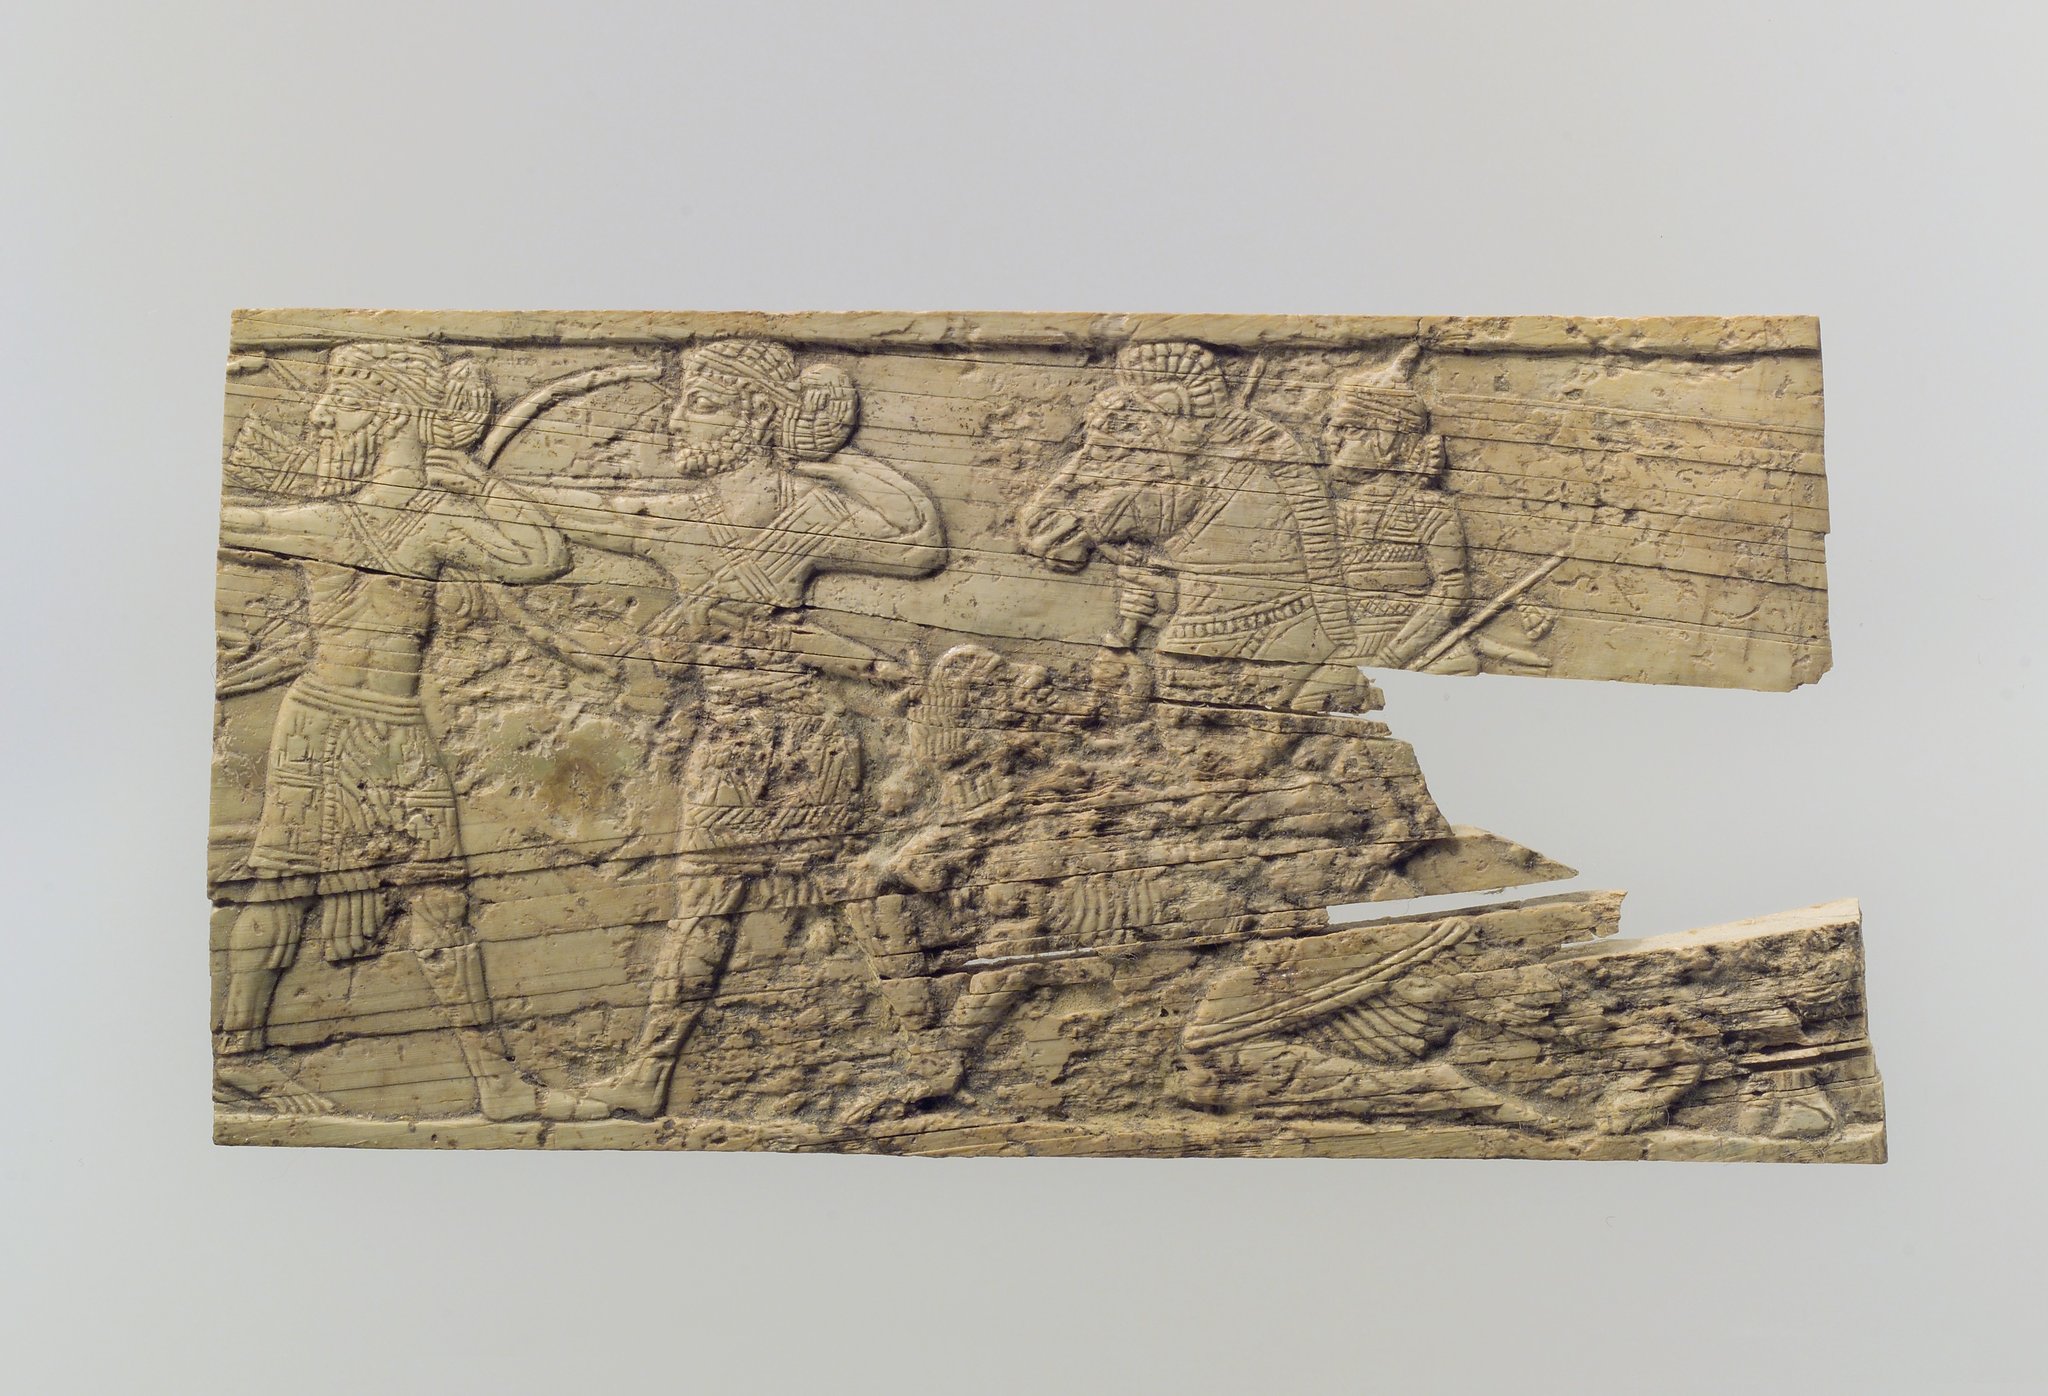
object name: relief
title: Panel fragment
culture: iranian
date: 800-601 BCE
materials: ivory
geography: iran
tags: battles,bow and arrow,men,horses